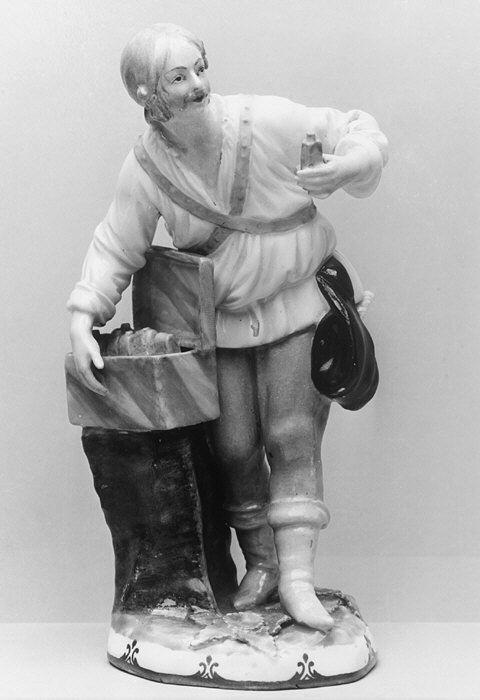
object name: figure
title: Brandy seller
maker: imperial porcelain manufactory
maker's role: manufactory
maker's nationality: austrian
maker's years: 1744-1864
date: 1755-1760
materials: hard paste porcelain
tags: men